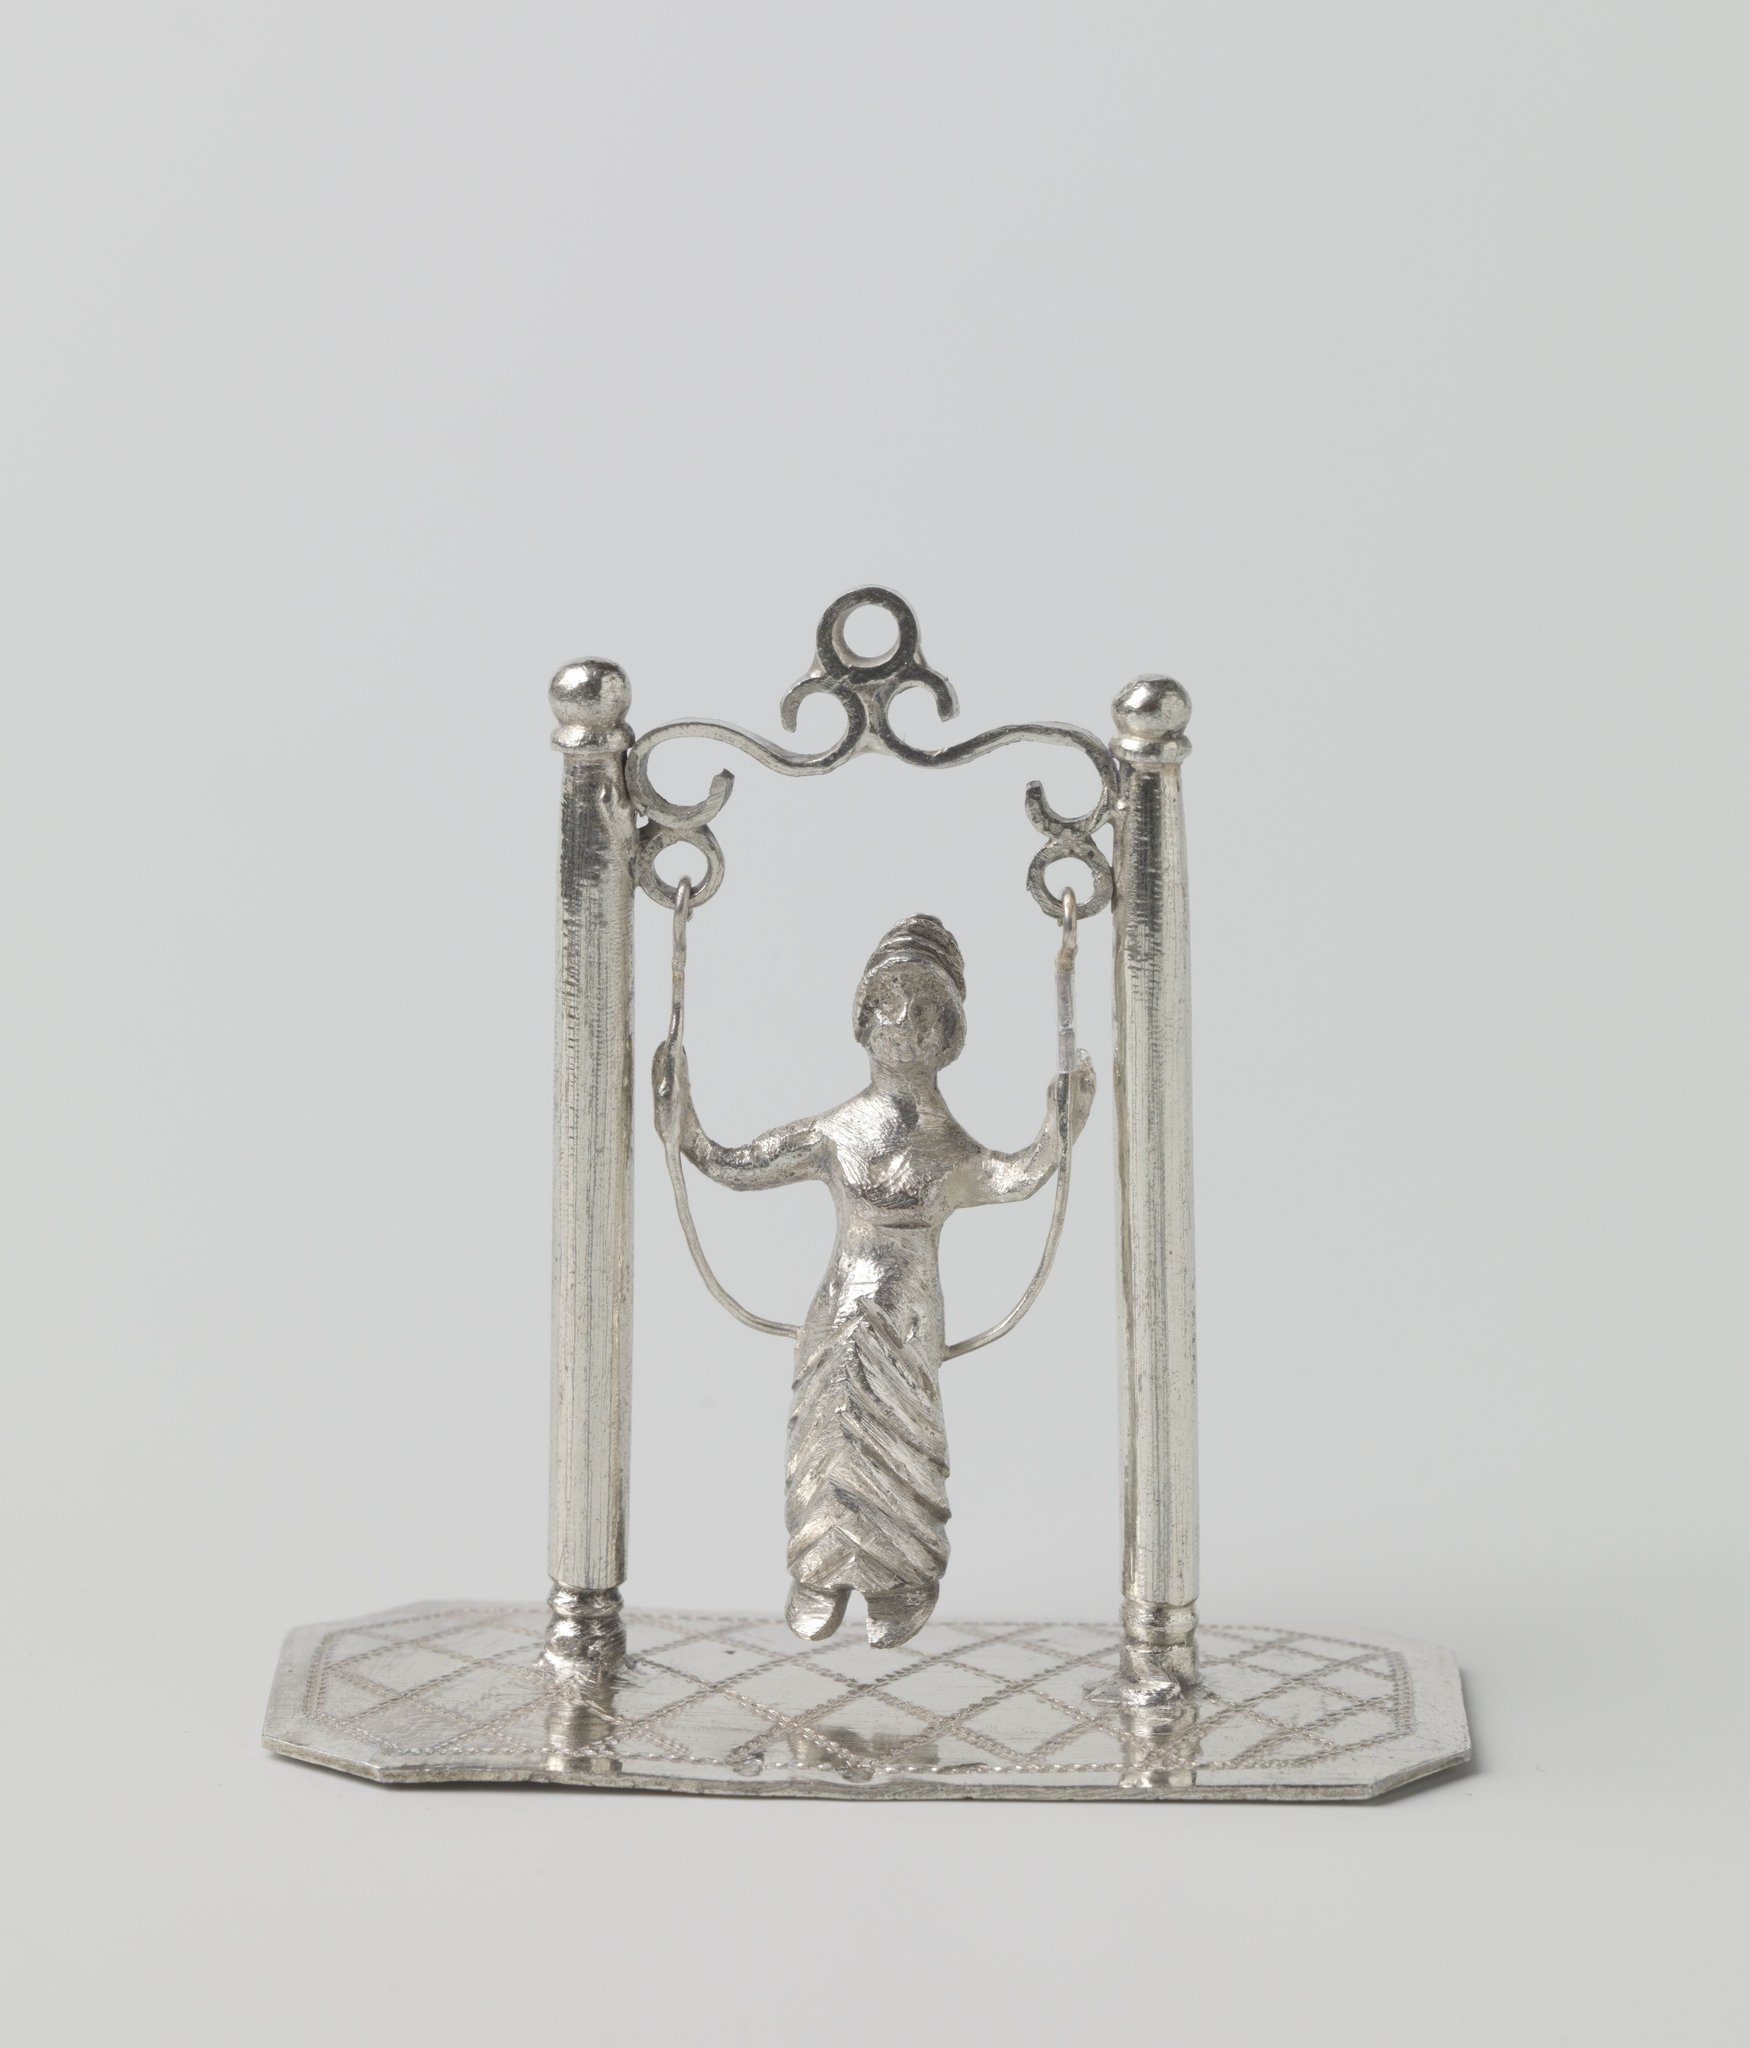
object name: miniature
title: Kind op schommel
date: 1822-1827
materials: silver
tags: swing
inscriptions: maker's mark: ‘B+’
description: Op een langwerpige plaat staat een schommel waarop een vrouw zit. In de plaat is een ruitpatroon gegraveerd. Het beeld is gemerkt met tweemaal een dolfijn en een meesterteken.